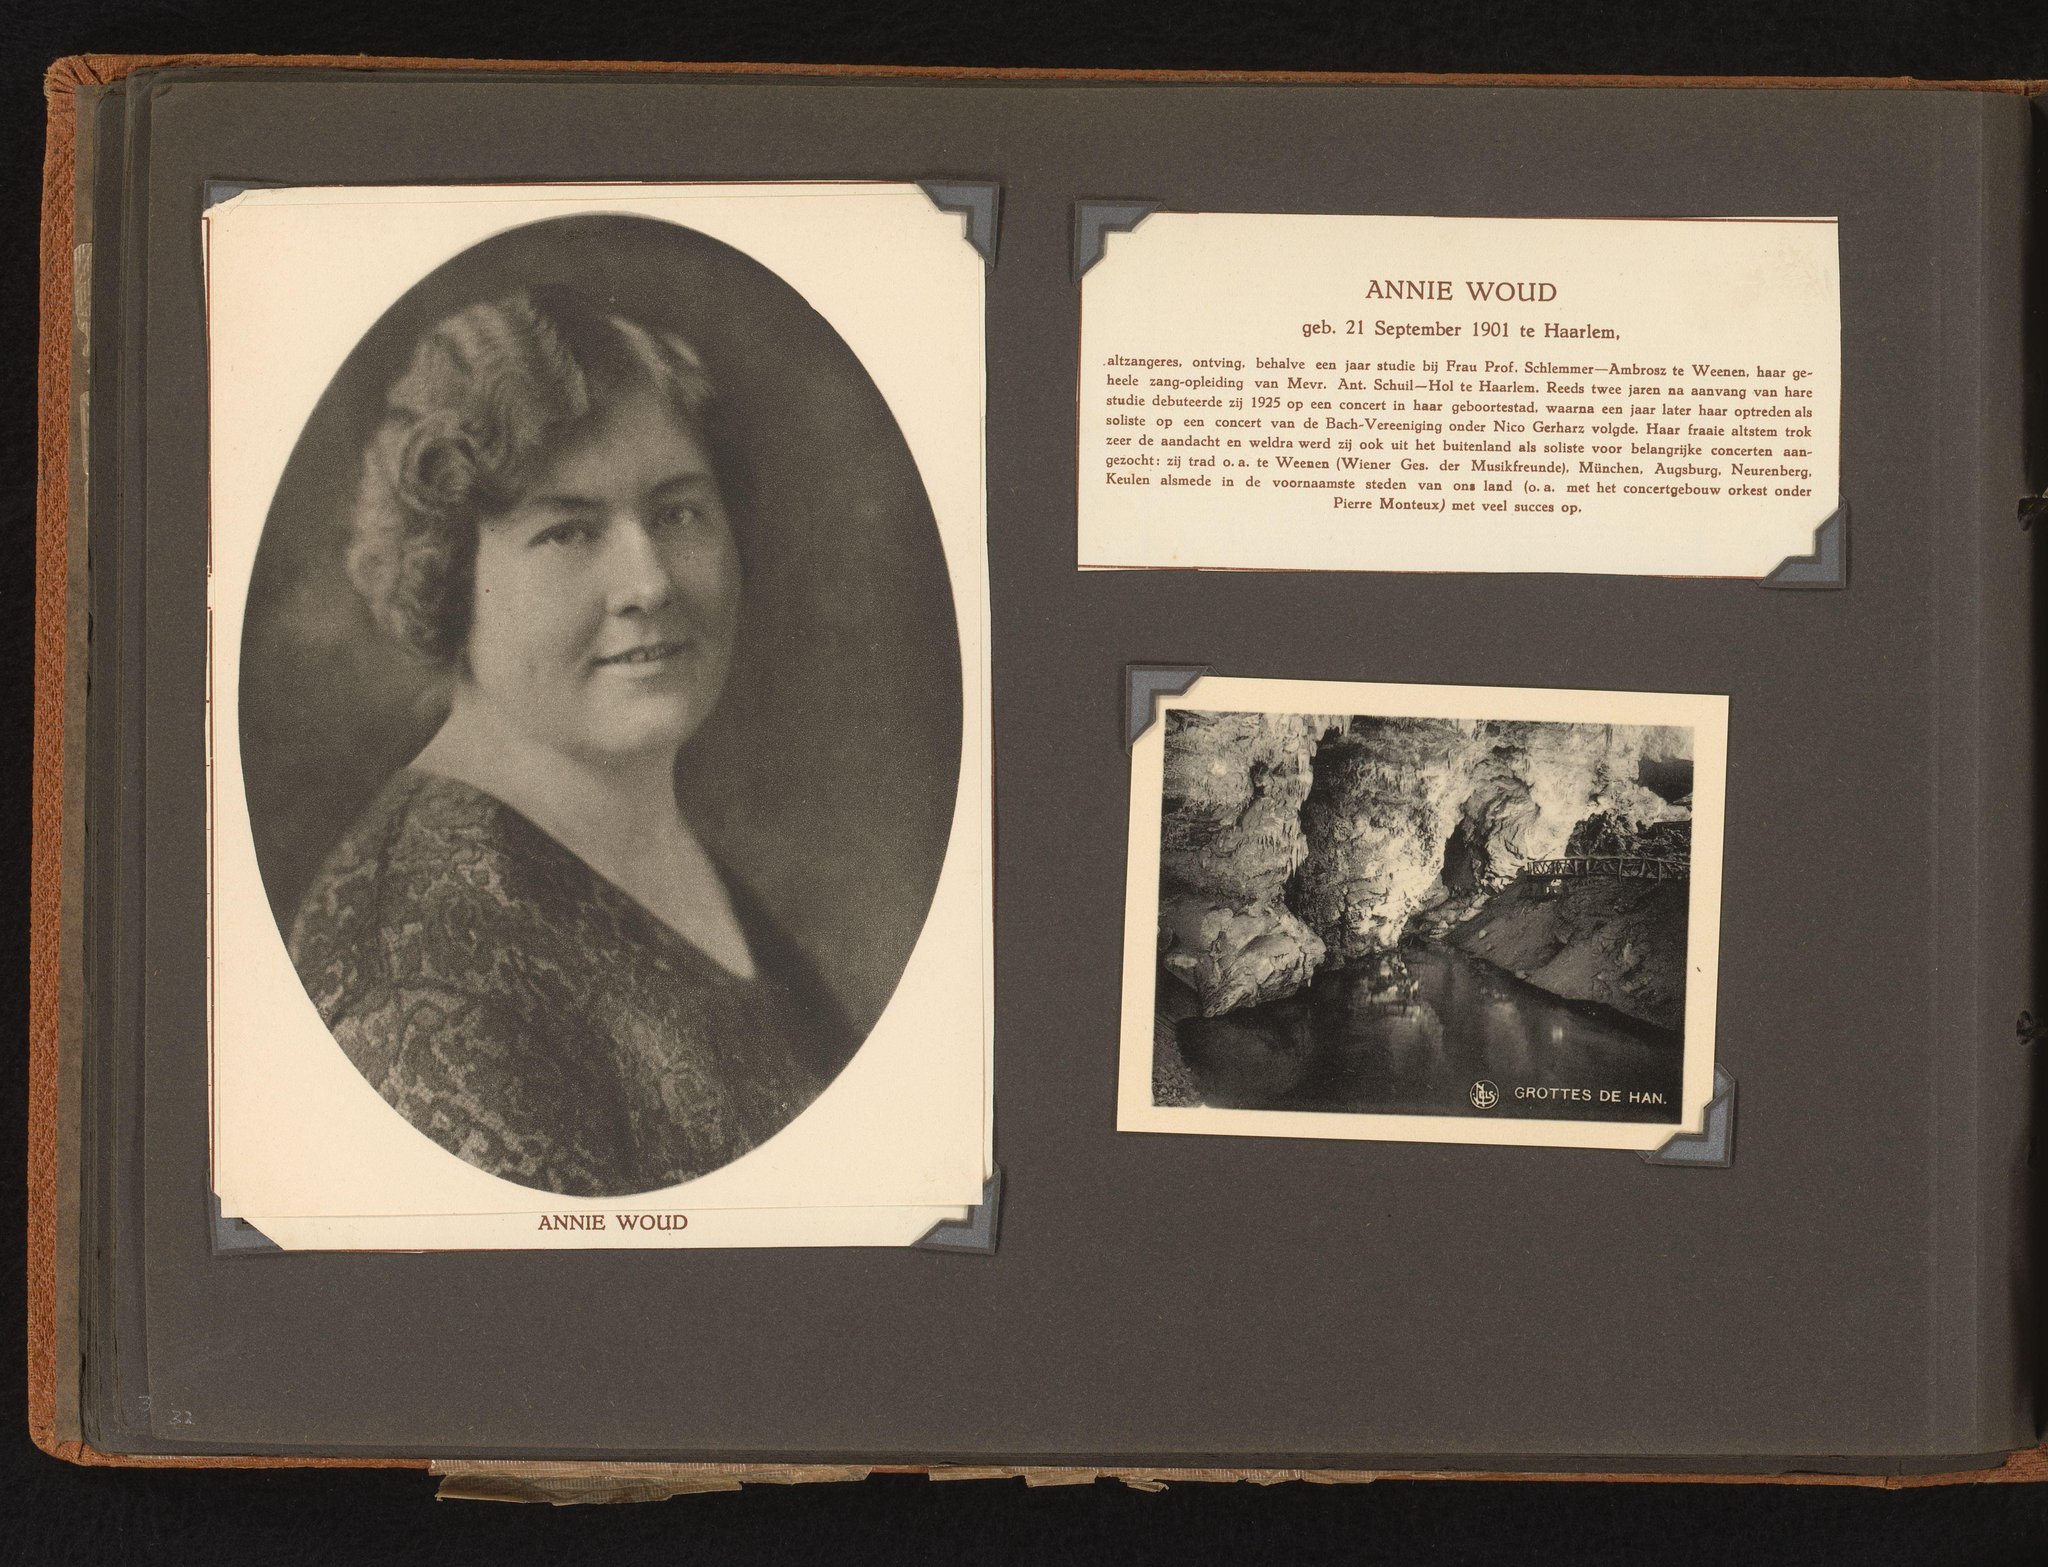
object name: photomechanical print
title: Annie Woud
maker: weijert jan van zanen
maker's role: fotograaf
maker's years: 1873-1960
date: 1933-1936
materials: paper, photographic support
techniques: gelatin silver print, rotogravure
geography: haarlem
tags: cave, grotto, opera-singer (female)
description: Albumblad met een portret van en een tekst over de alt Annie Woud, plus een foto van de grotten van Han. Onderdeel van het Esperanto album uit ca. 1933-1936.